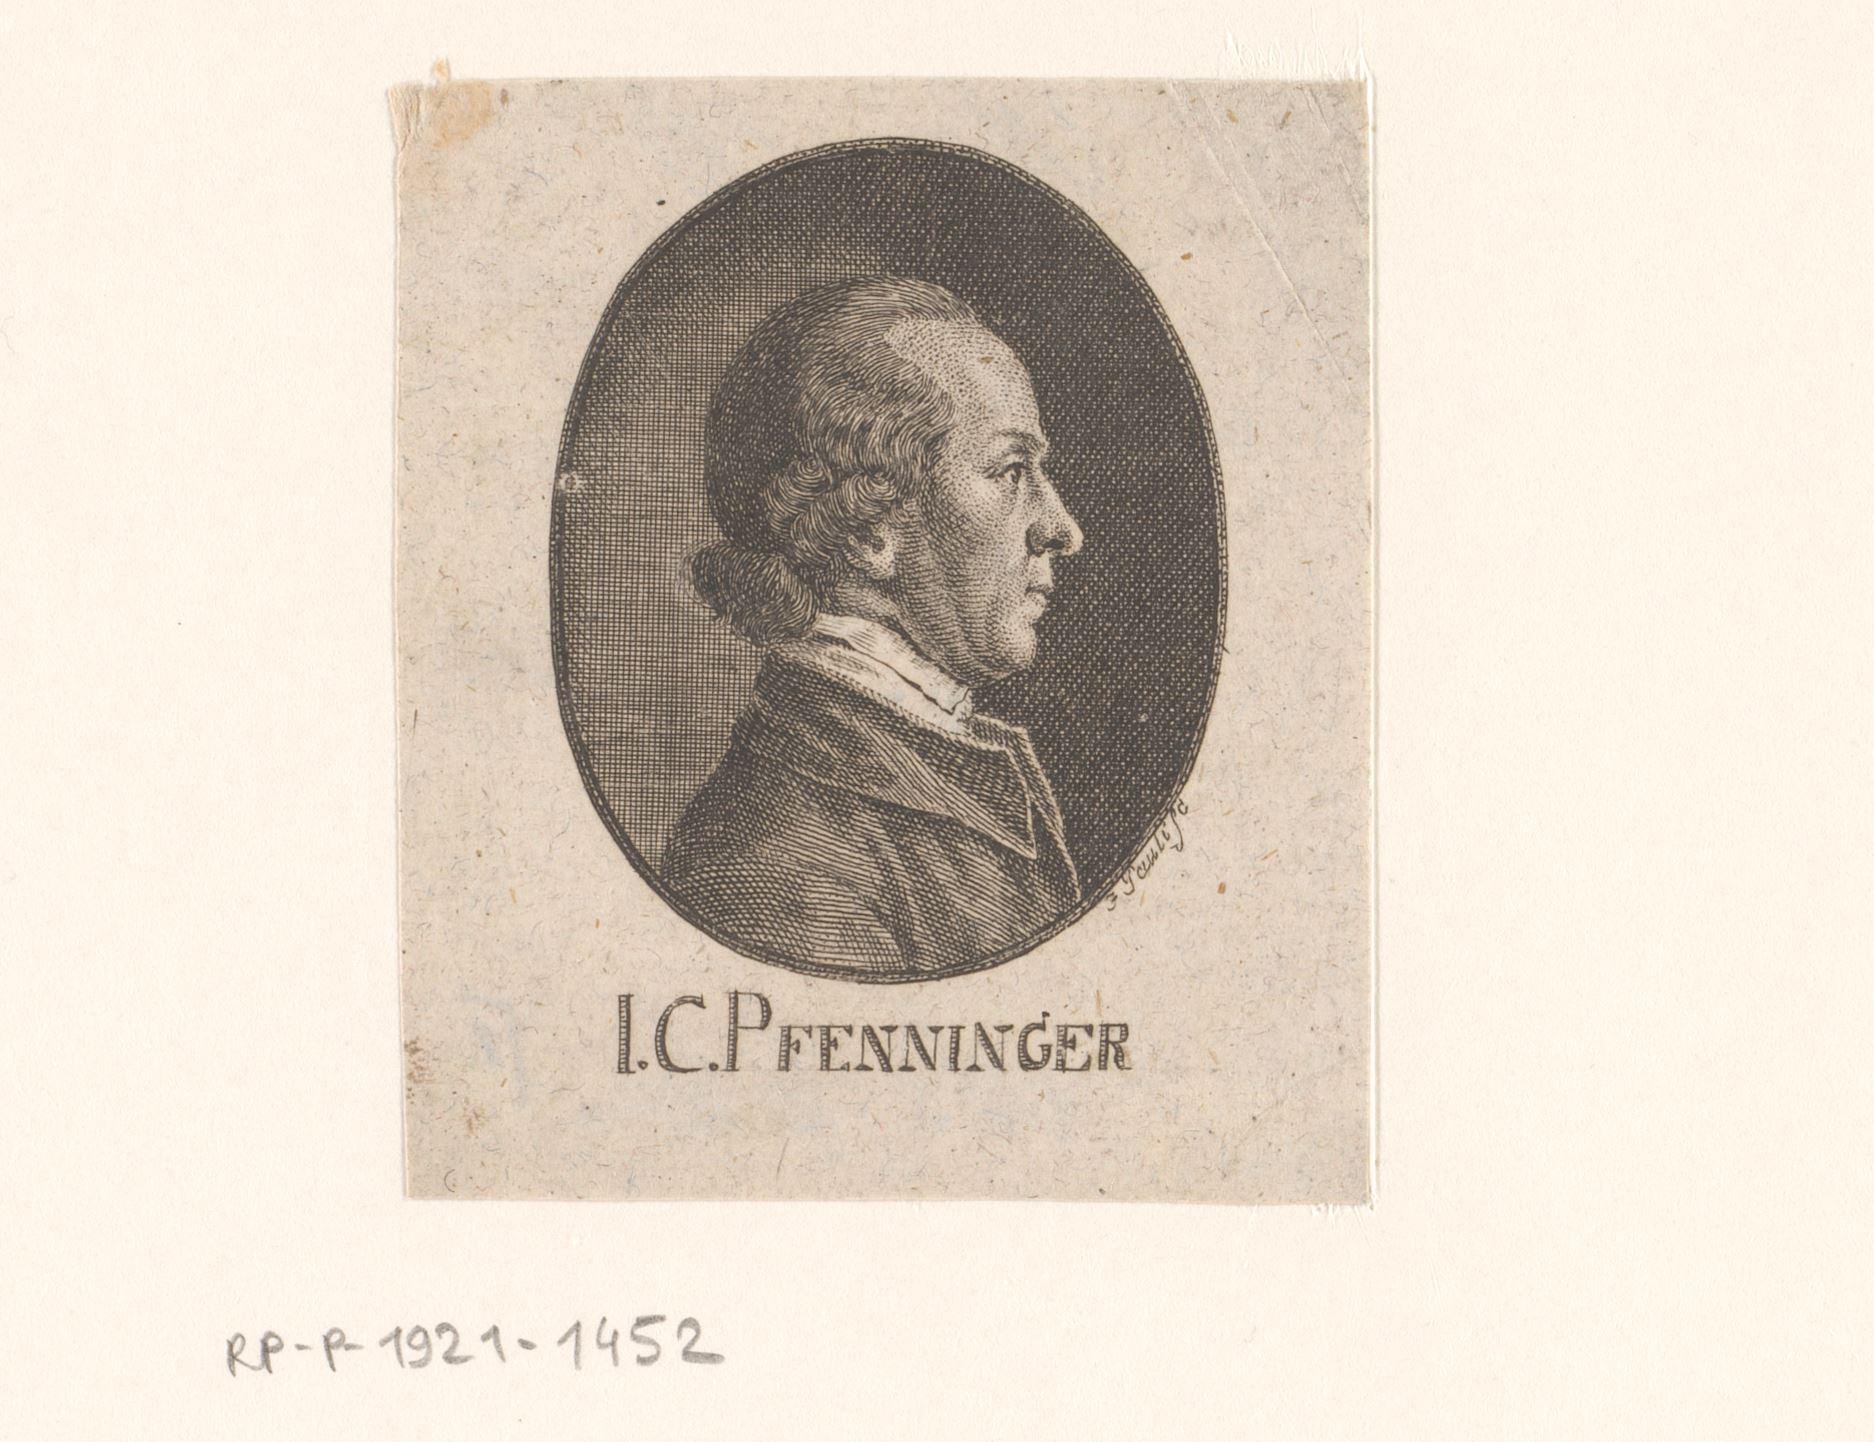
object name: print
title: Portret van Johann Konrad Pfenninger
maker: j. pauli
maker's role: print maker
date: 1793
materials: paper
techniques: etching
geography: germany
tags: theologian, historical persons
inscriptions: inscription: ‘in Franken aanwezig/ Gm’, collector's mark: Lugt 2233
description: Prent waarschijnlijk uit: Olla potrida: eine Quartalschrift. Berlijn: Arnold Wever, 1793, dl. 1.